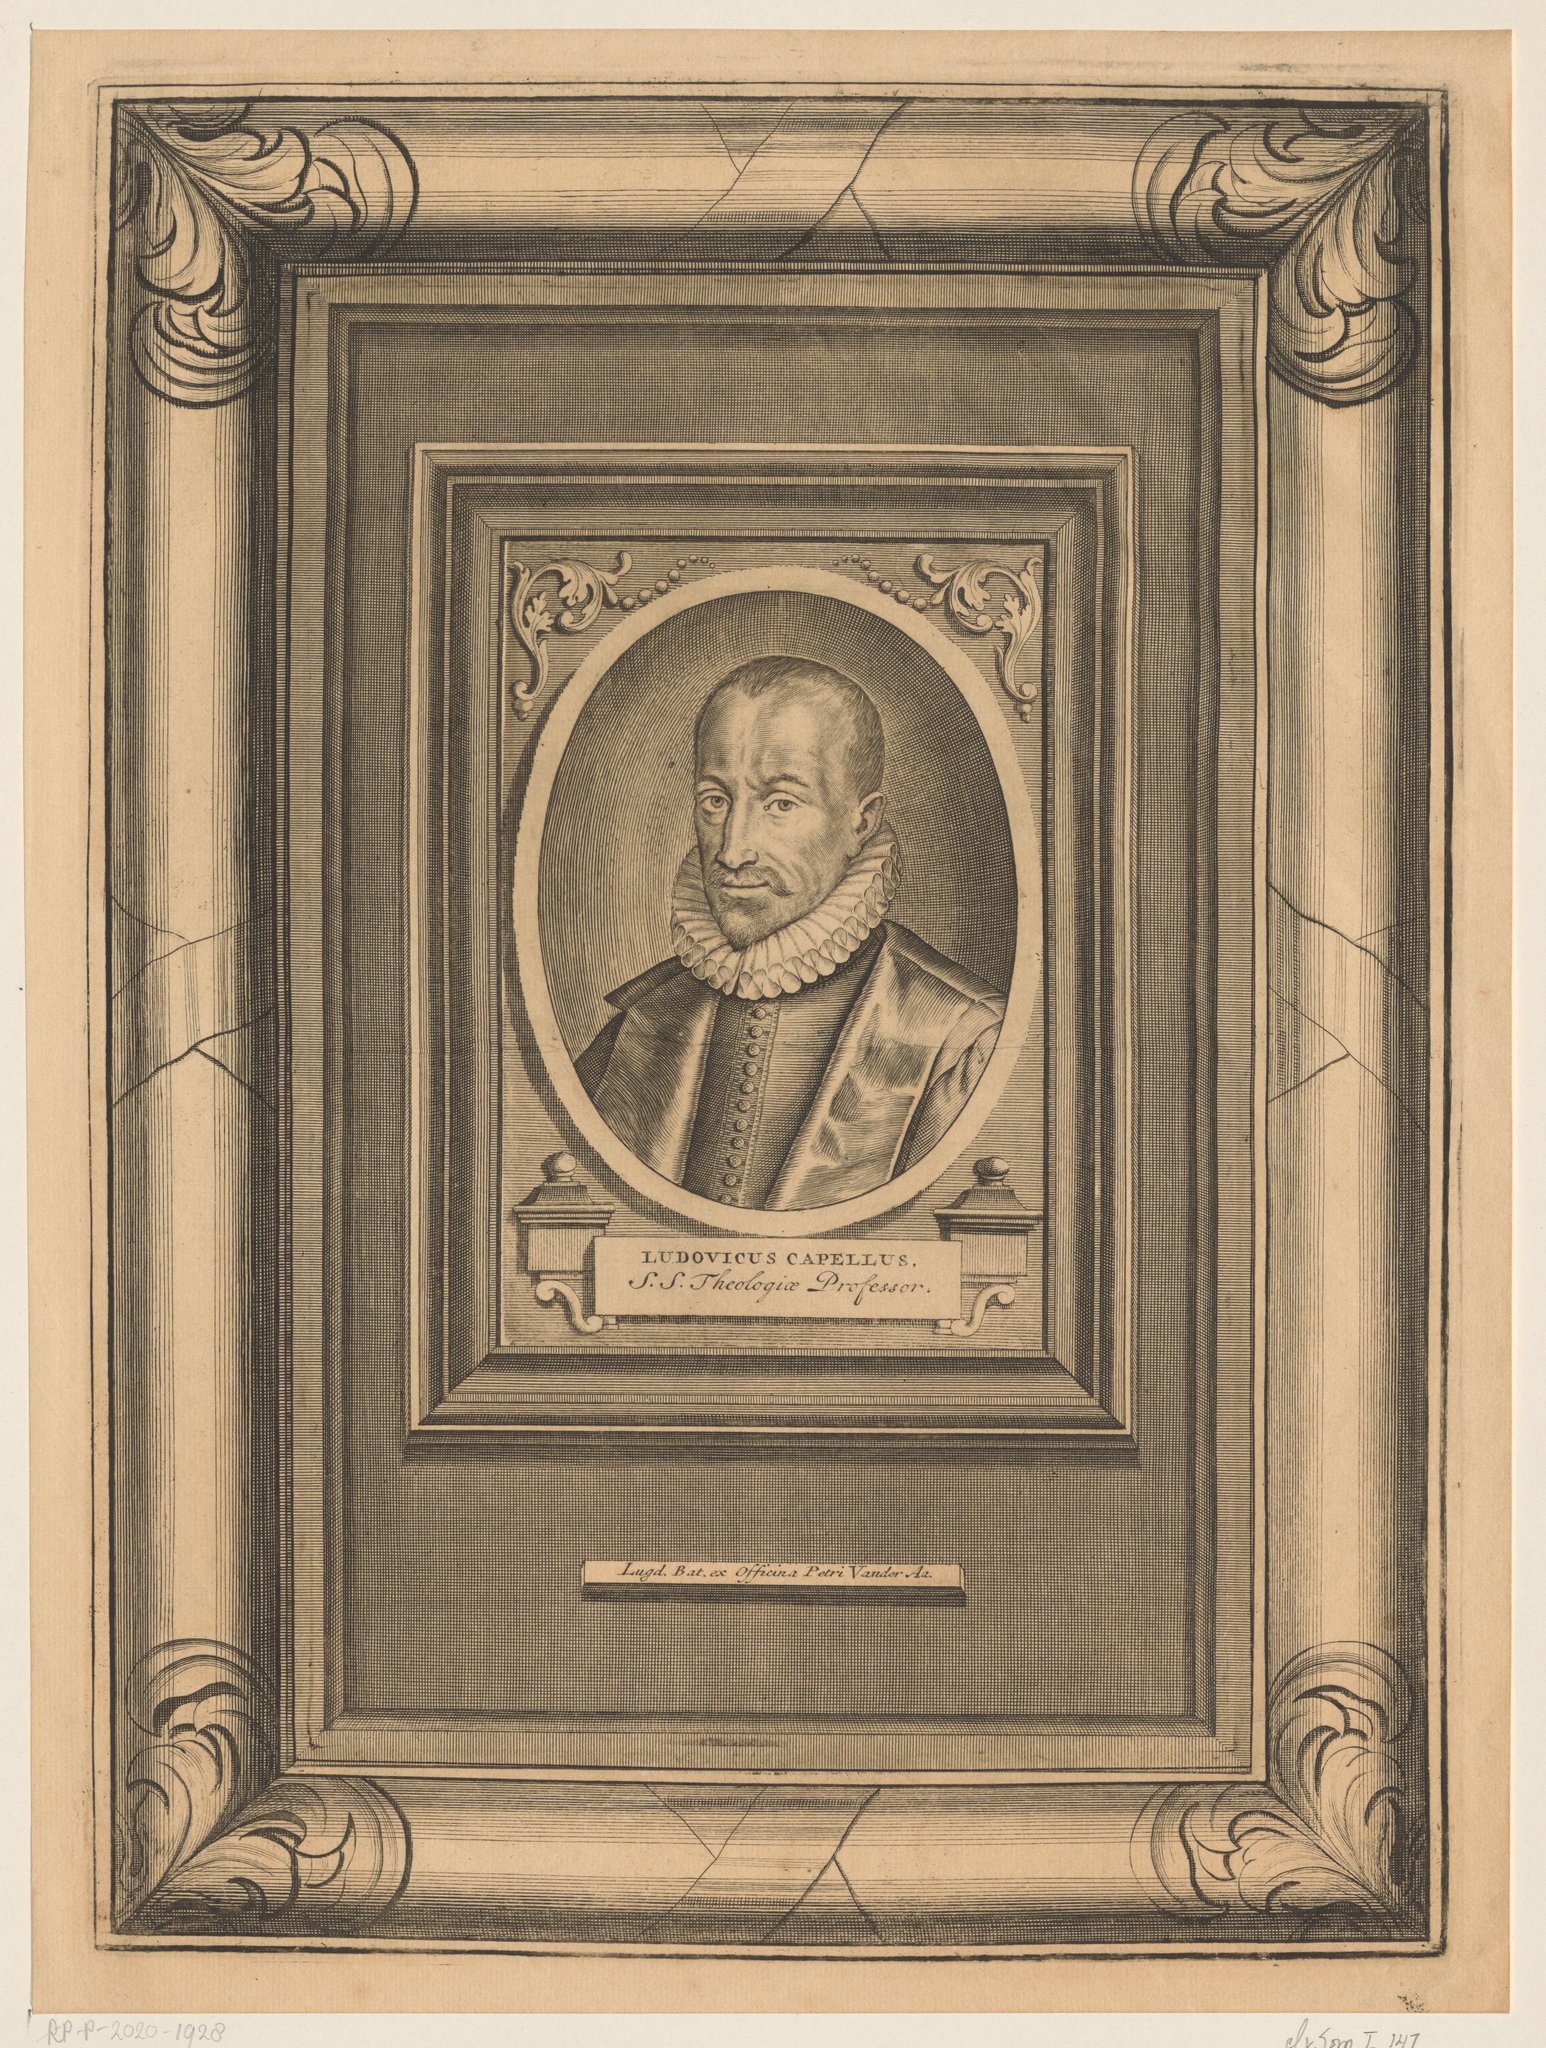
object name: print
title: Portret van Lodewijk Cappellus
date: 1668-1733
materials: paper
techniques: engraving, etching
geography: leiden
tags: historical persons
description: Prent zonder omlijsting gebruikt in: Fundatoris curatorum et professorum celeberrimorum, (...) academia Lugduno-Batava (...). Leiden: Pieter van der Aa I, [1716].